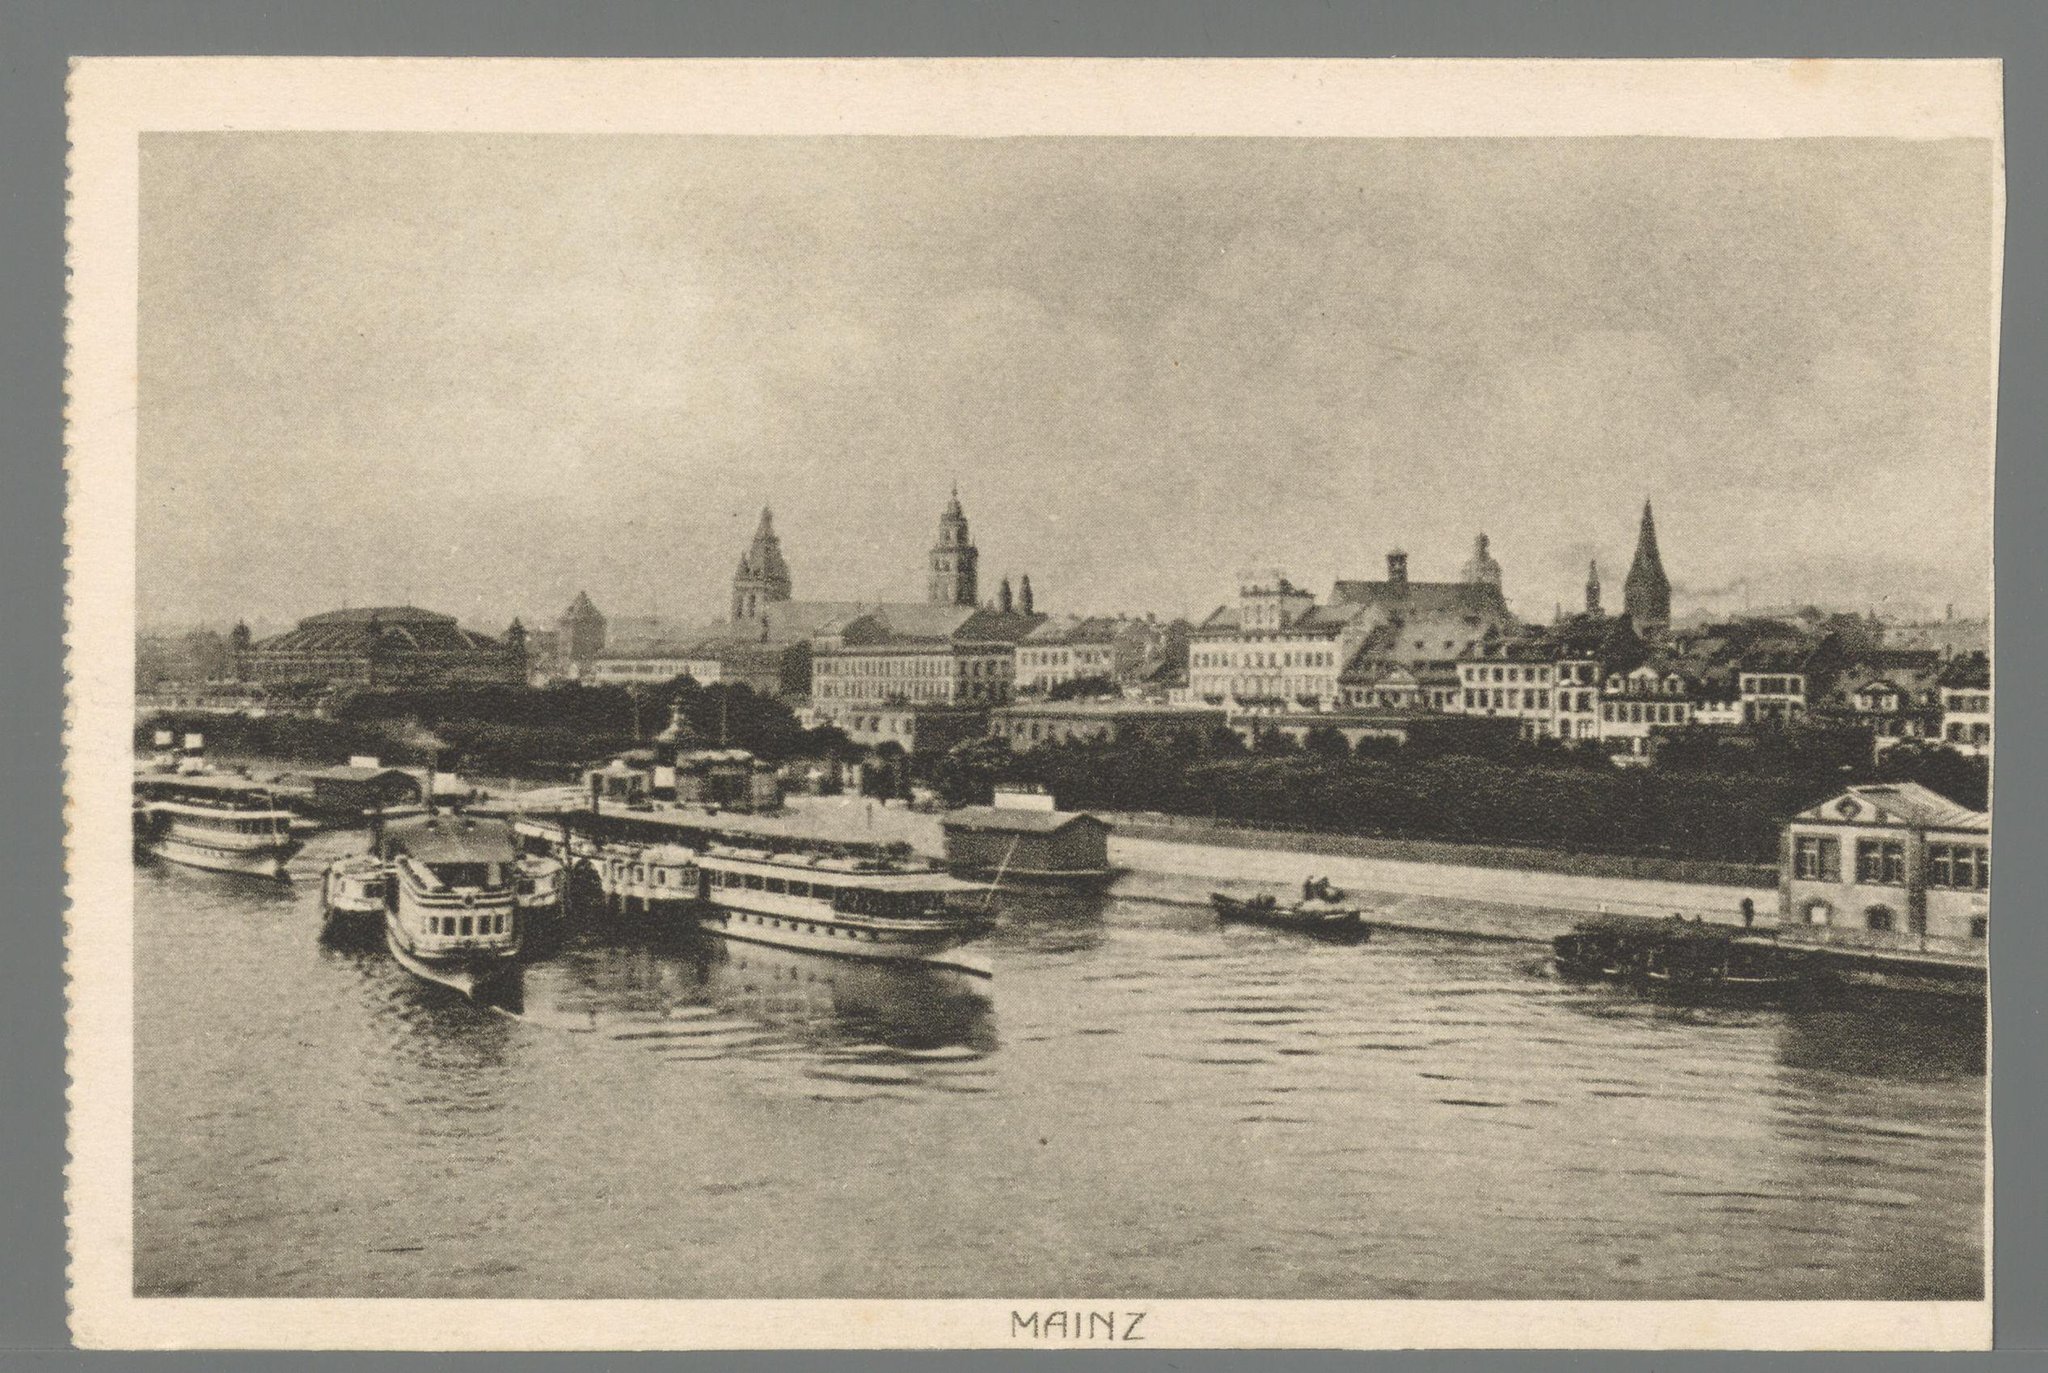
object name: ansichtkaart, prentbriefkaart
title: Mainz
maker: Anonymous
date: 1905-1930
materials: cardboard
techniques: rotogravure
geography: siegburg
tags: city-view, and landscape with man-made constructions, canals, waters (in city)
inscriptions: monogram: ‘K.T.F.’